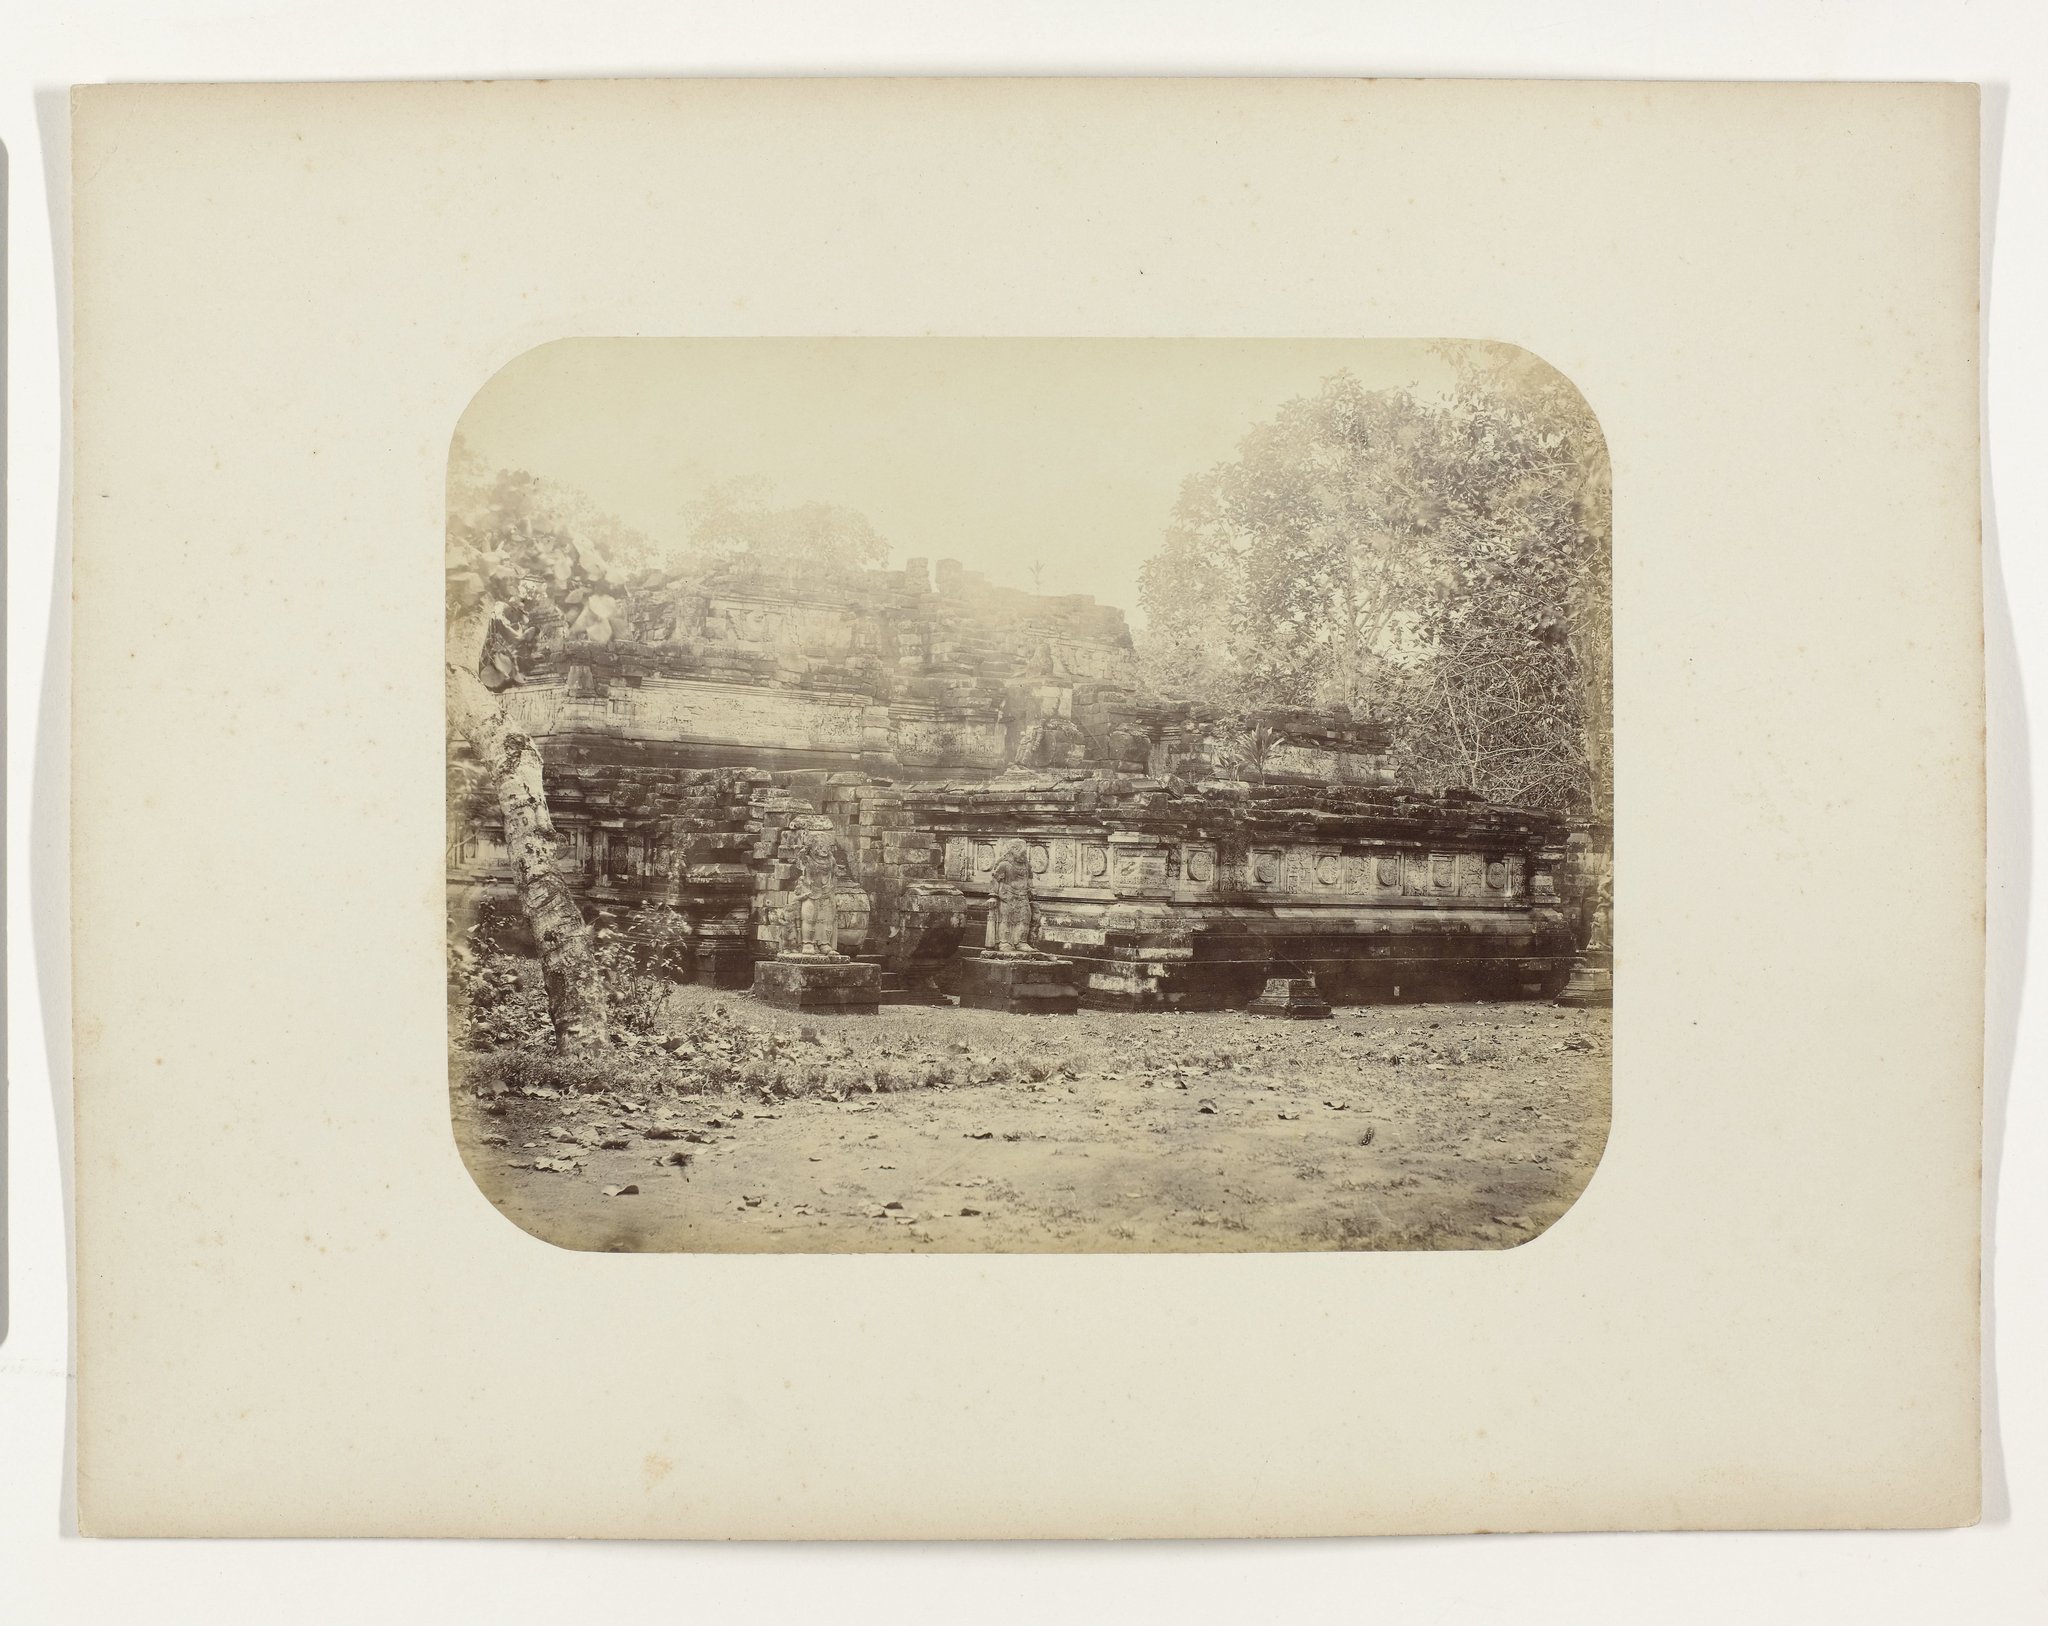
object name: photograph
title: Een Hindoetempel bij Jogyakarta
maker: herman salzwedel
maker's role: fotograaf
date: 1876-1884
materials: photographic support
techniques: albumen print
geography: surabaya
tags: utrecht, the hague, colonial system, places and objects of worship ~ hinduism, buddhism, jainism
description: Een Hindoetempel bij Jogyakarta, misschien Panataran, in matige conditie met links twee Hindoebeelden. Onderdeel van het fotoalbum door de Soerabayasche Vereeniging van Suikerfabrikanten aangeboden aan Frederik Beyerinck, resident van Soerabaja.